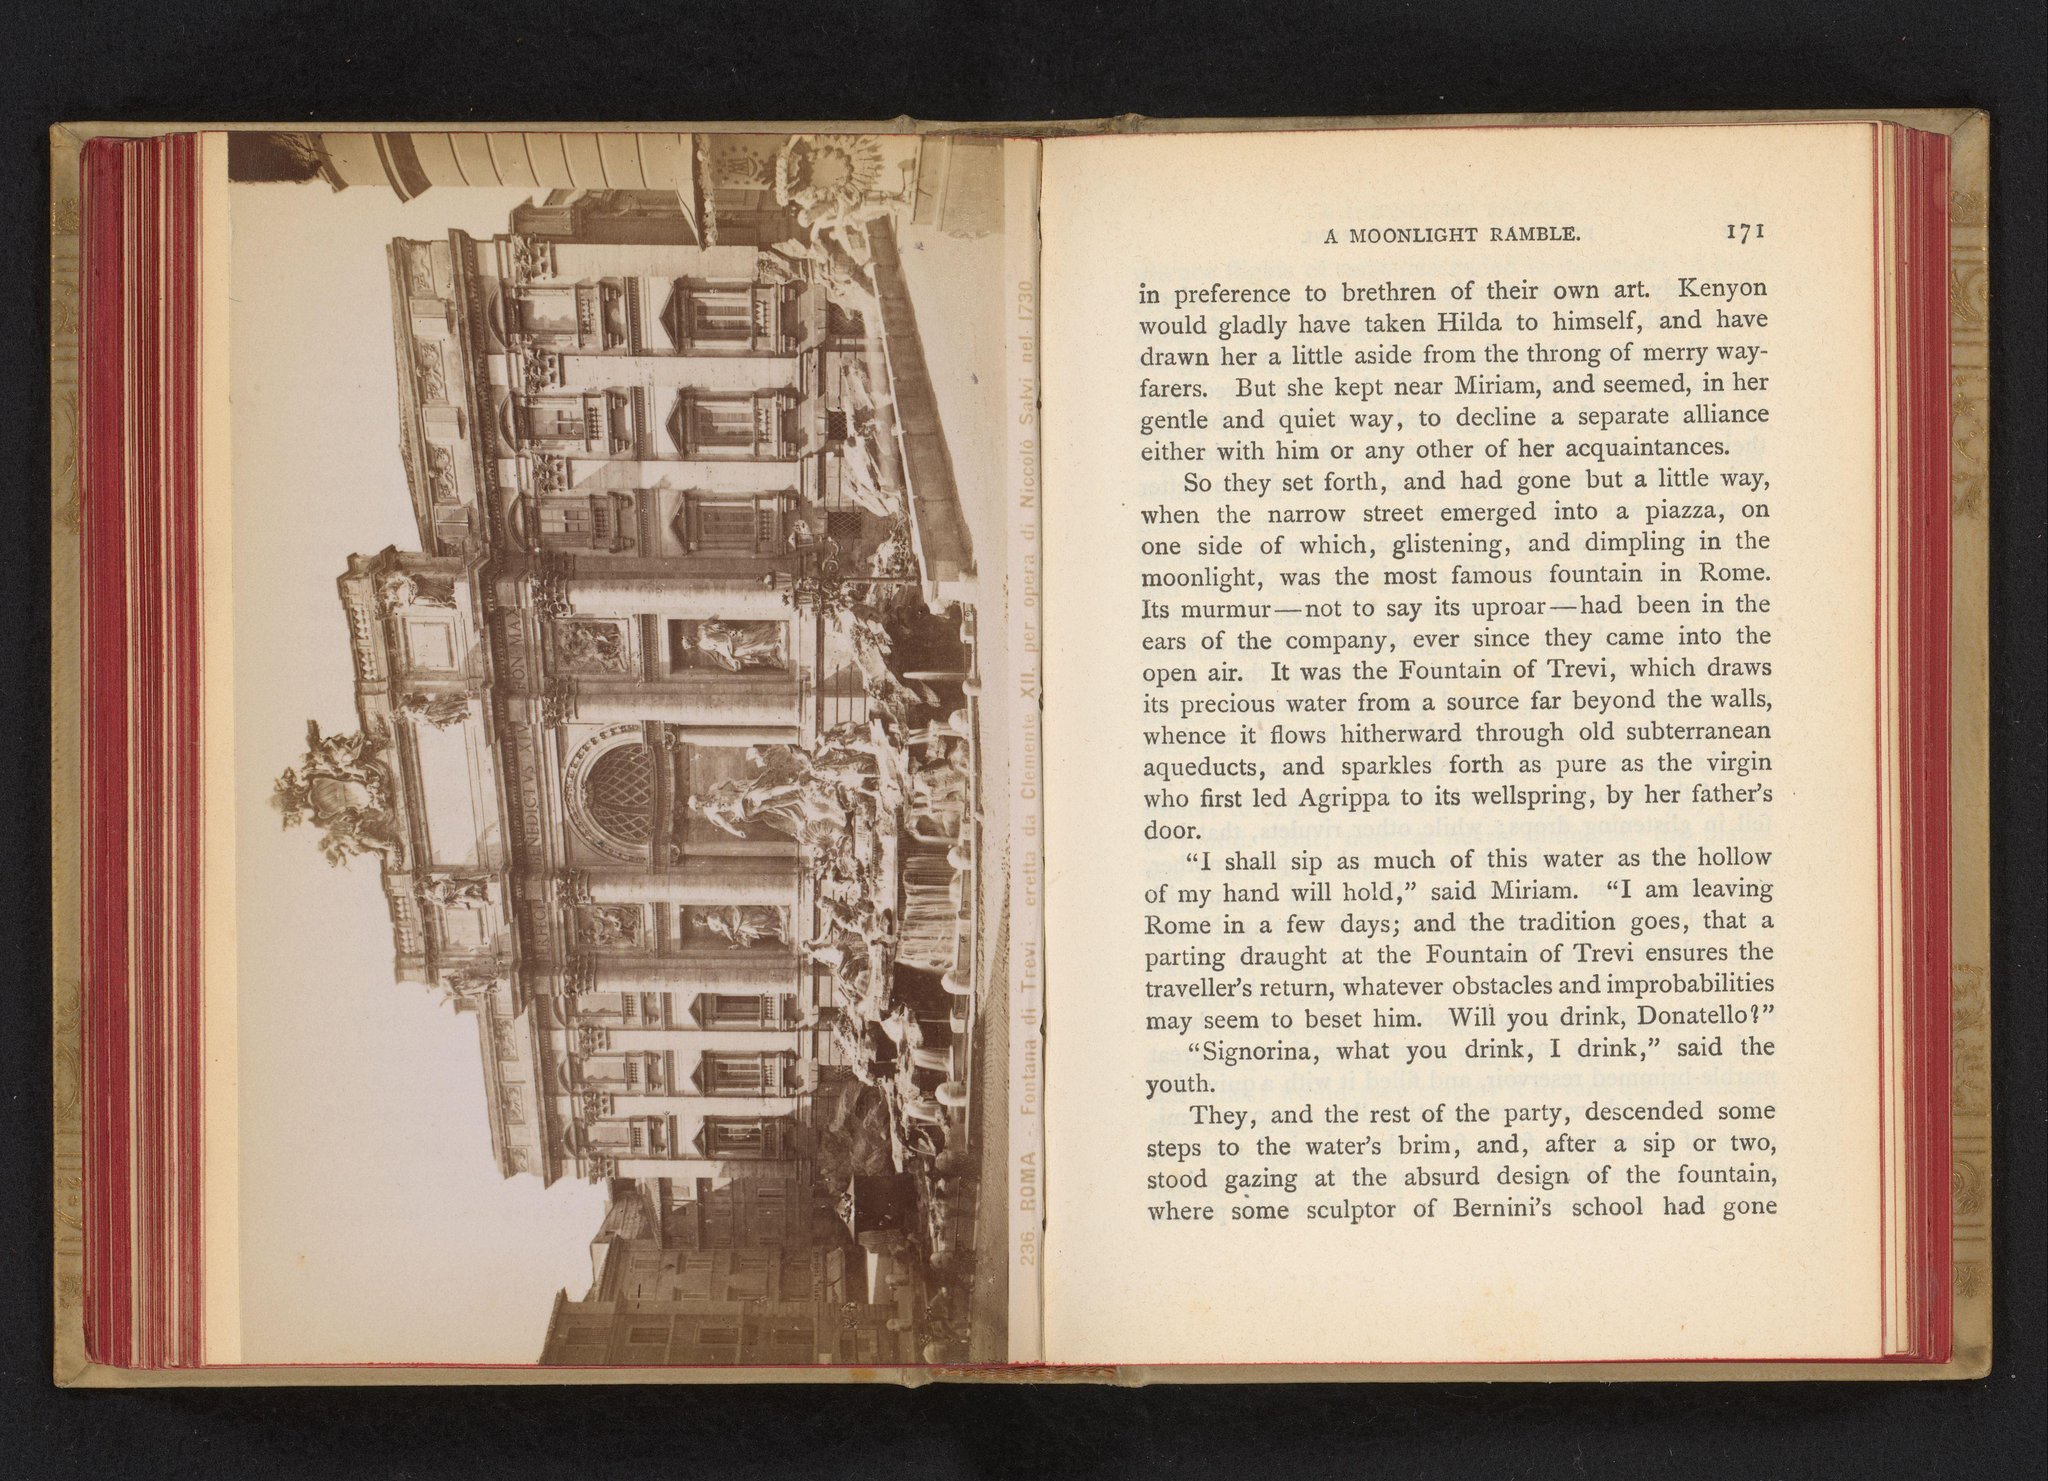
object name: photograph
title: Roma - Fontana di Trevi - eretta da Clemente XII, per opera di Niccolò Salvi nel 1730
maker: Anonymous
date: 1855-1860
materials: paper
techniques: albumen print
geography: rome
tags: ornamental fountain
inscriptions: number: ‘236.’